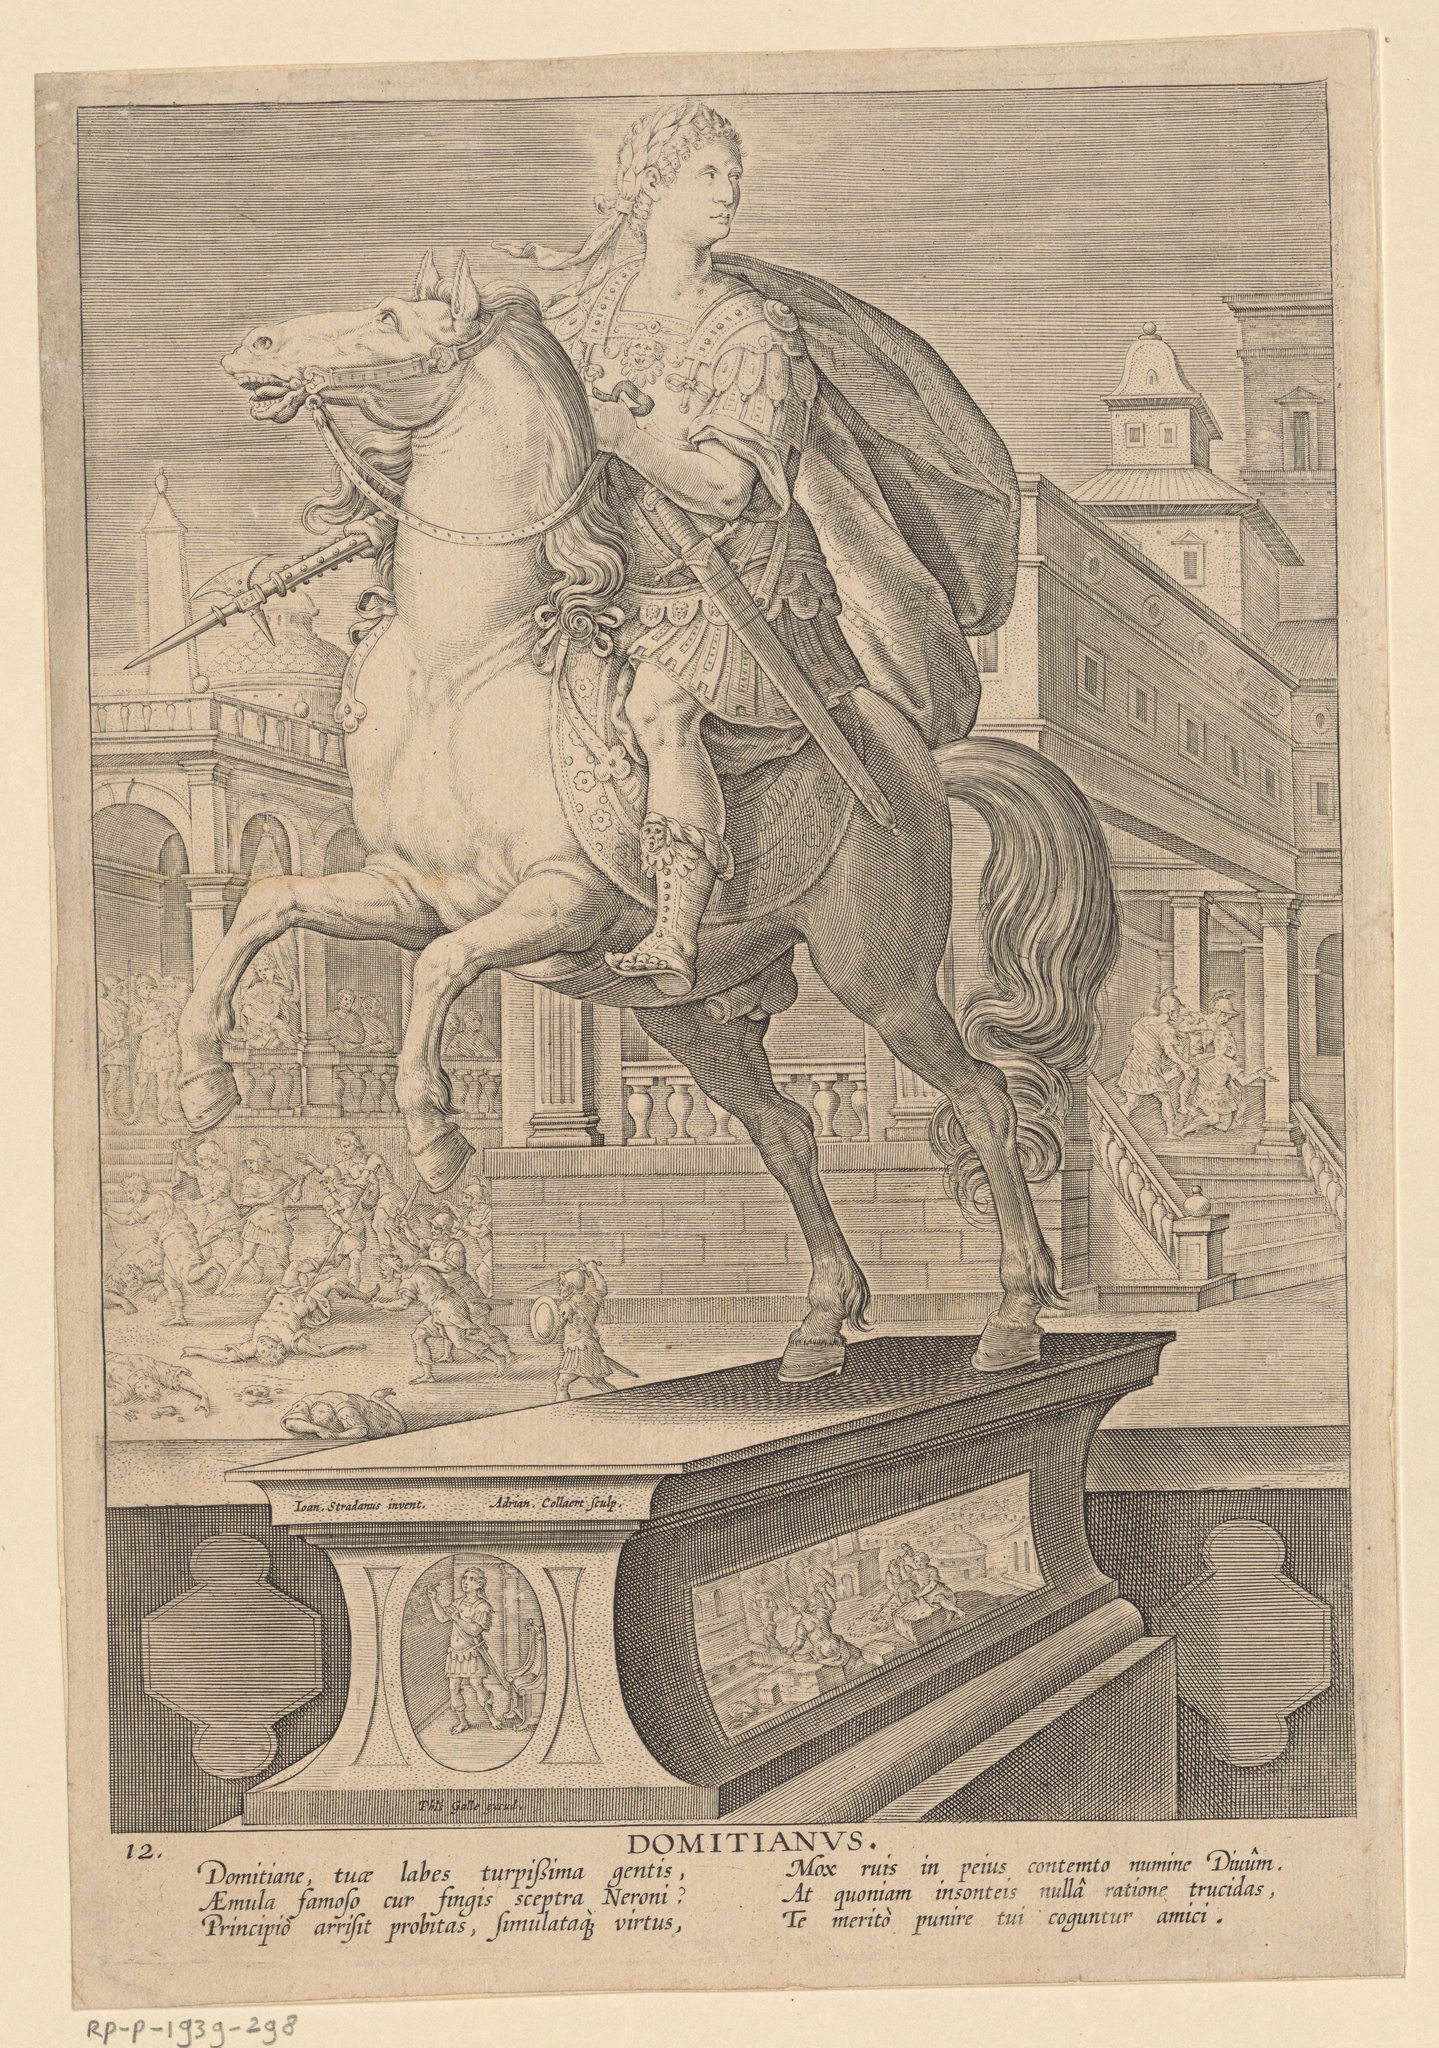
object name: print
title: Romeinse keizers te paard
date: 1587-1589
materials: paper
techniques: engraving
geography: antwerp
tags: equestrian state-portrait, male persons from classical history (domitianus, titus flavius) - portrait of person from classical history, historical persons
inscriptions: collector's mark: Lugt 2228, collector's mark: Lugt 2760